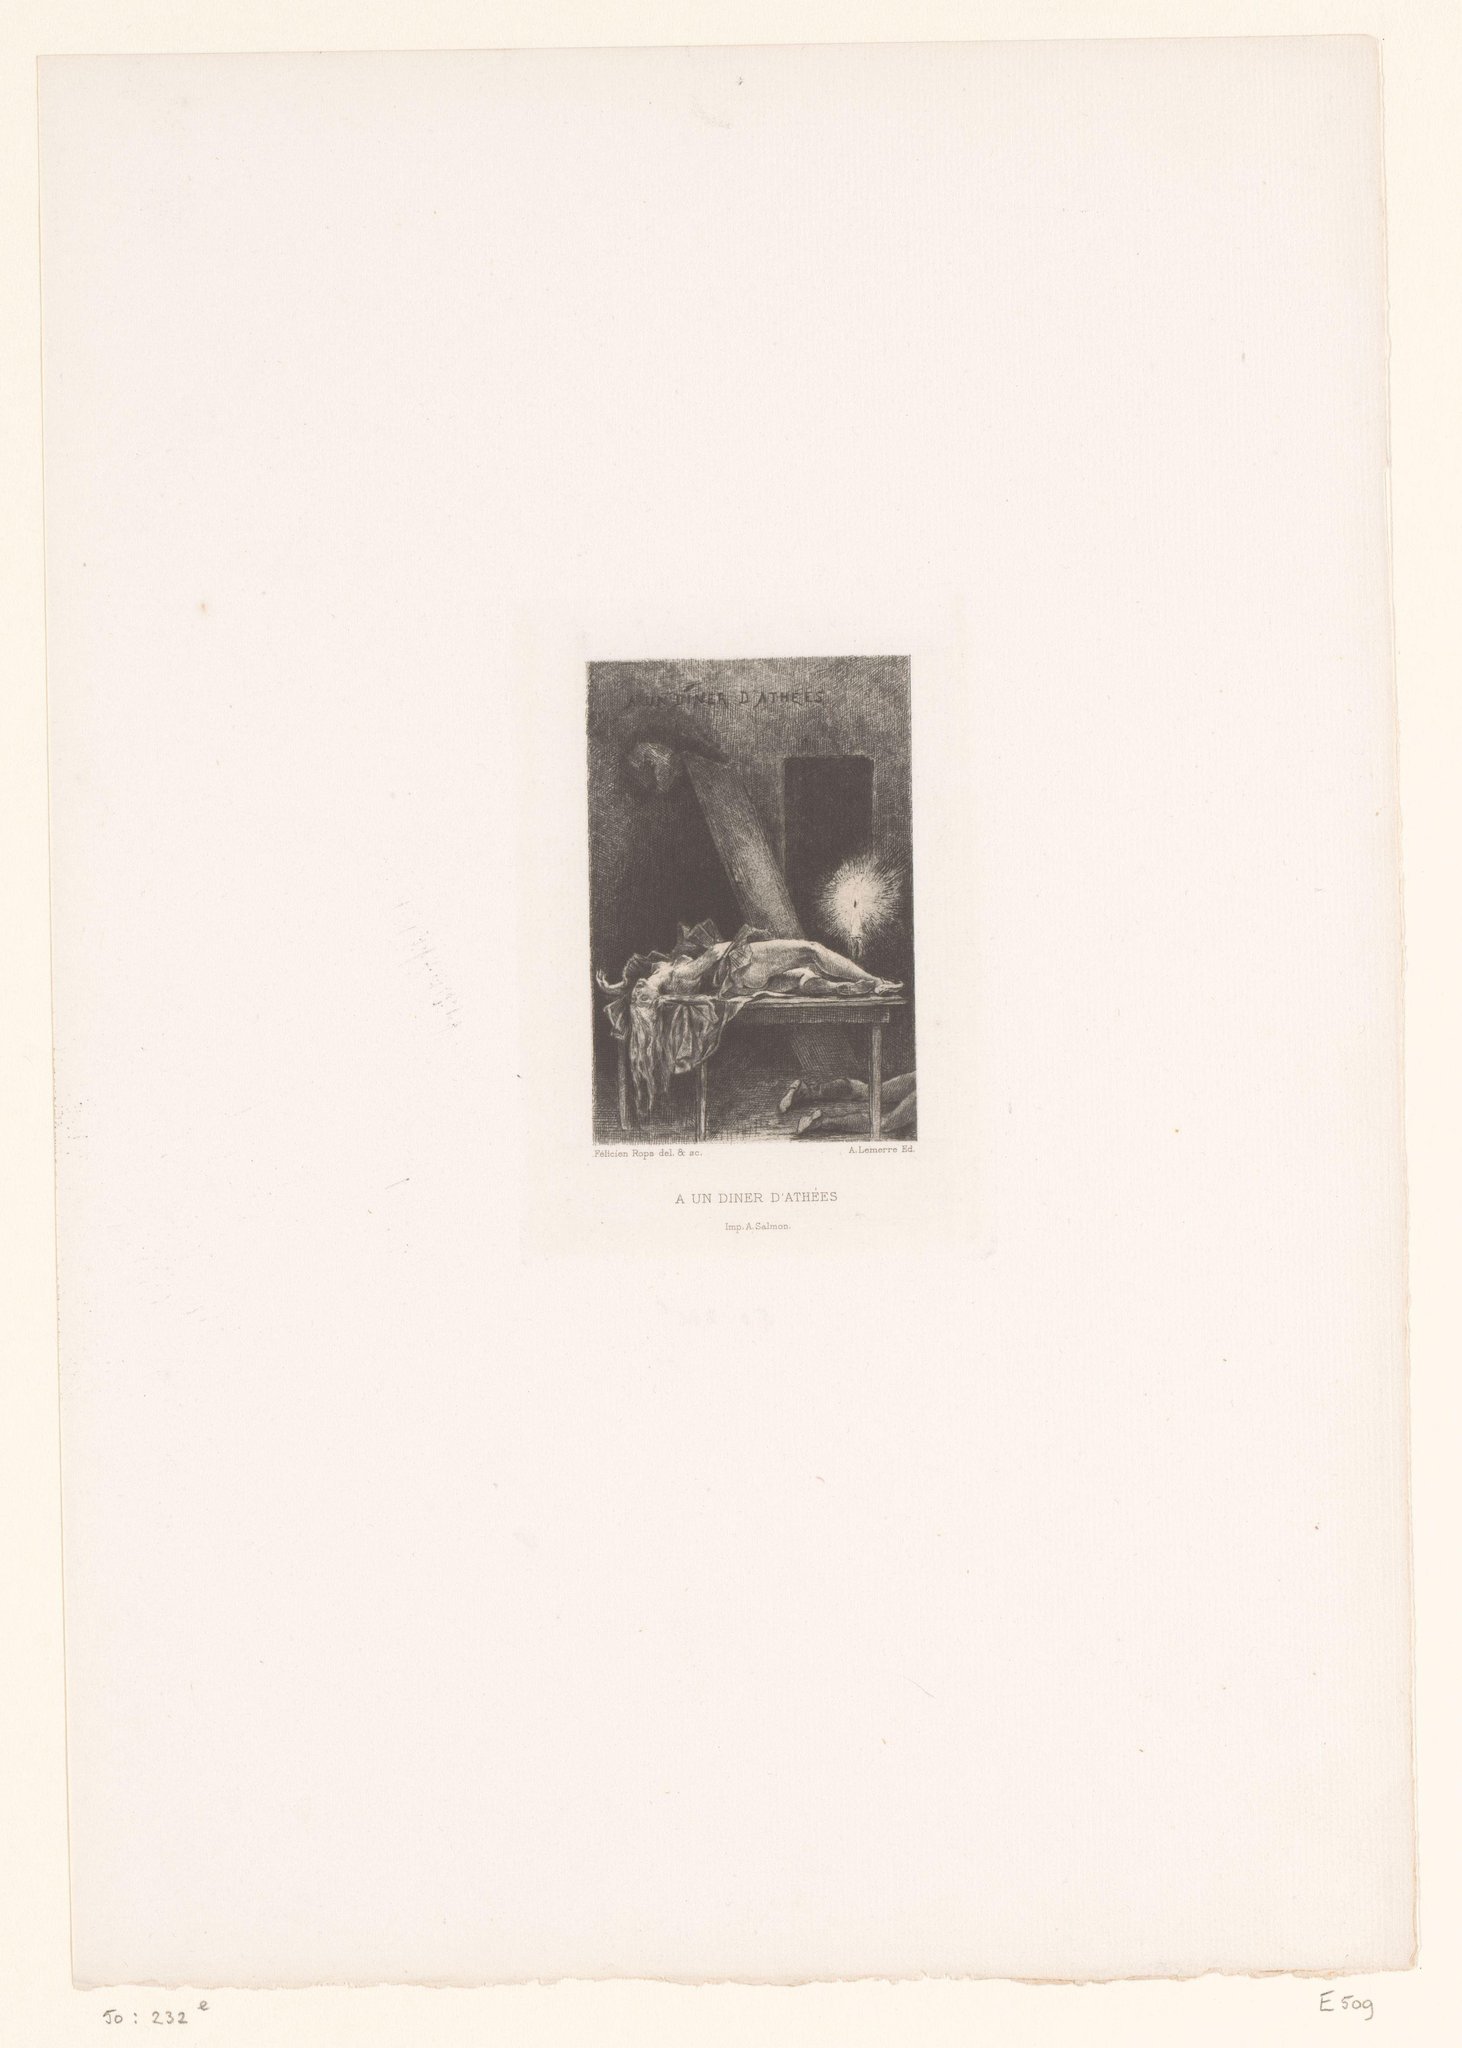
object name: print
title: Tien etsen ter illustratie van 'Les diaboliques'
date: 1886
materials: paper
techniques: etching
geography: paris